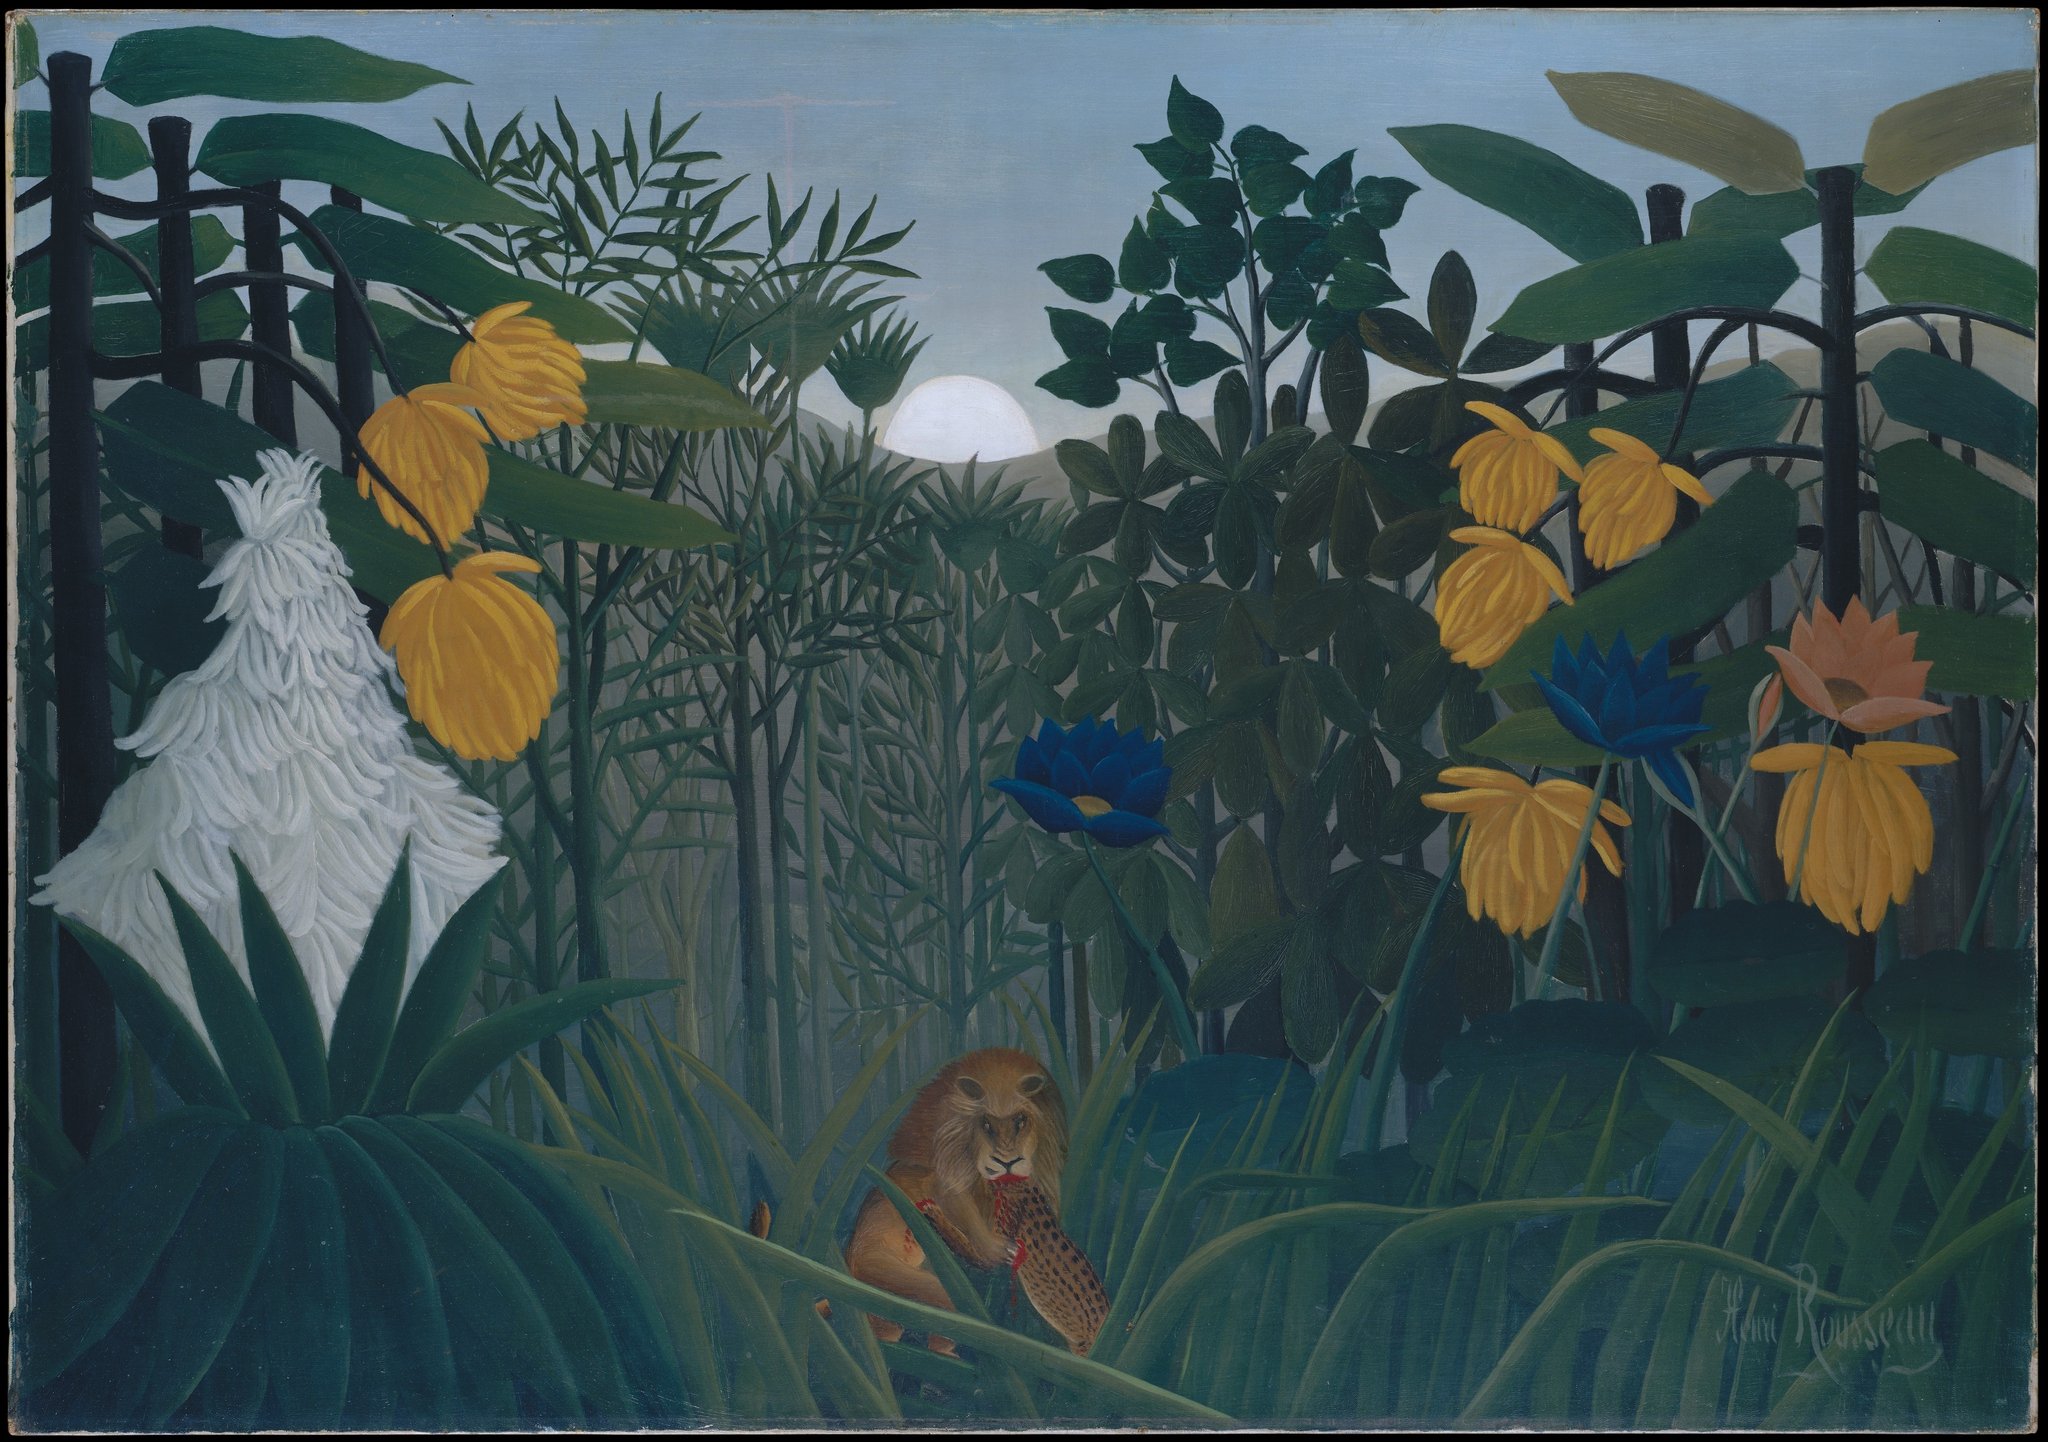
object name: painting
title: The Repast of the Lion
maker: henri rousseau (le douanier)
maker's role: artist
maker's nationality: french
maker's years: 1844-1910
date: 1907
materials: canvas, oil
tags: lions,forests